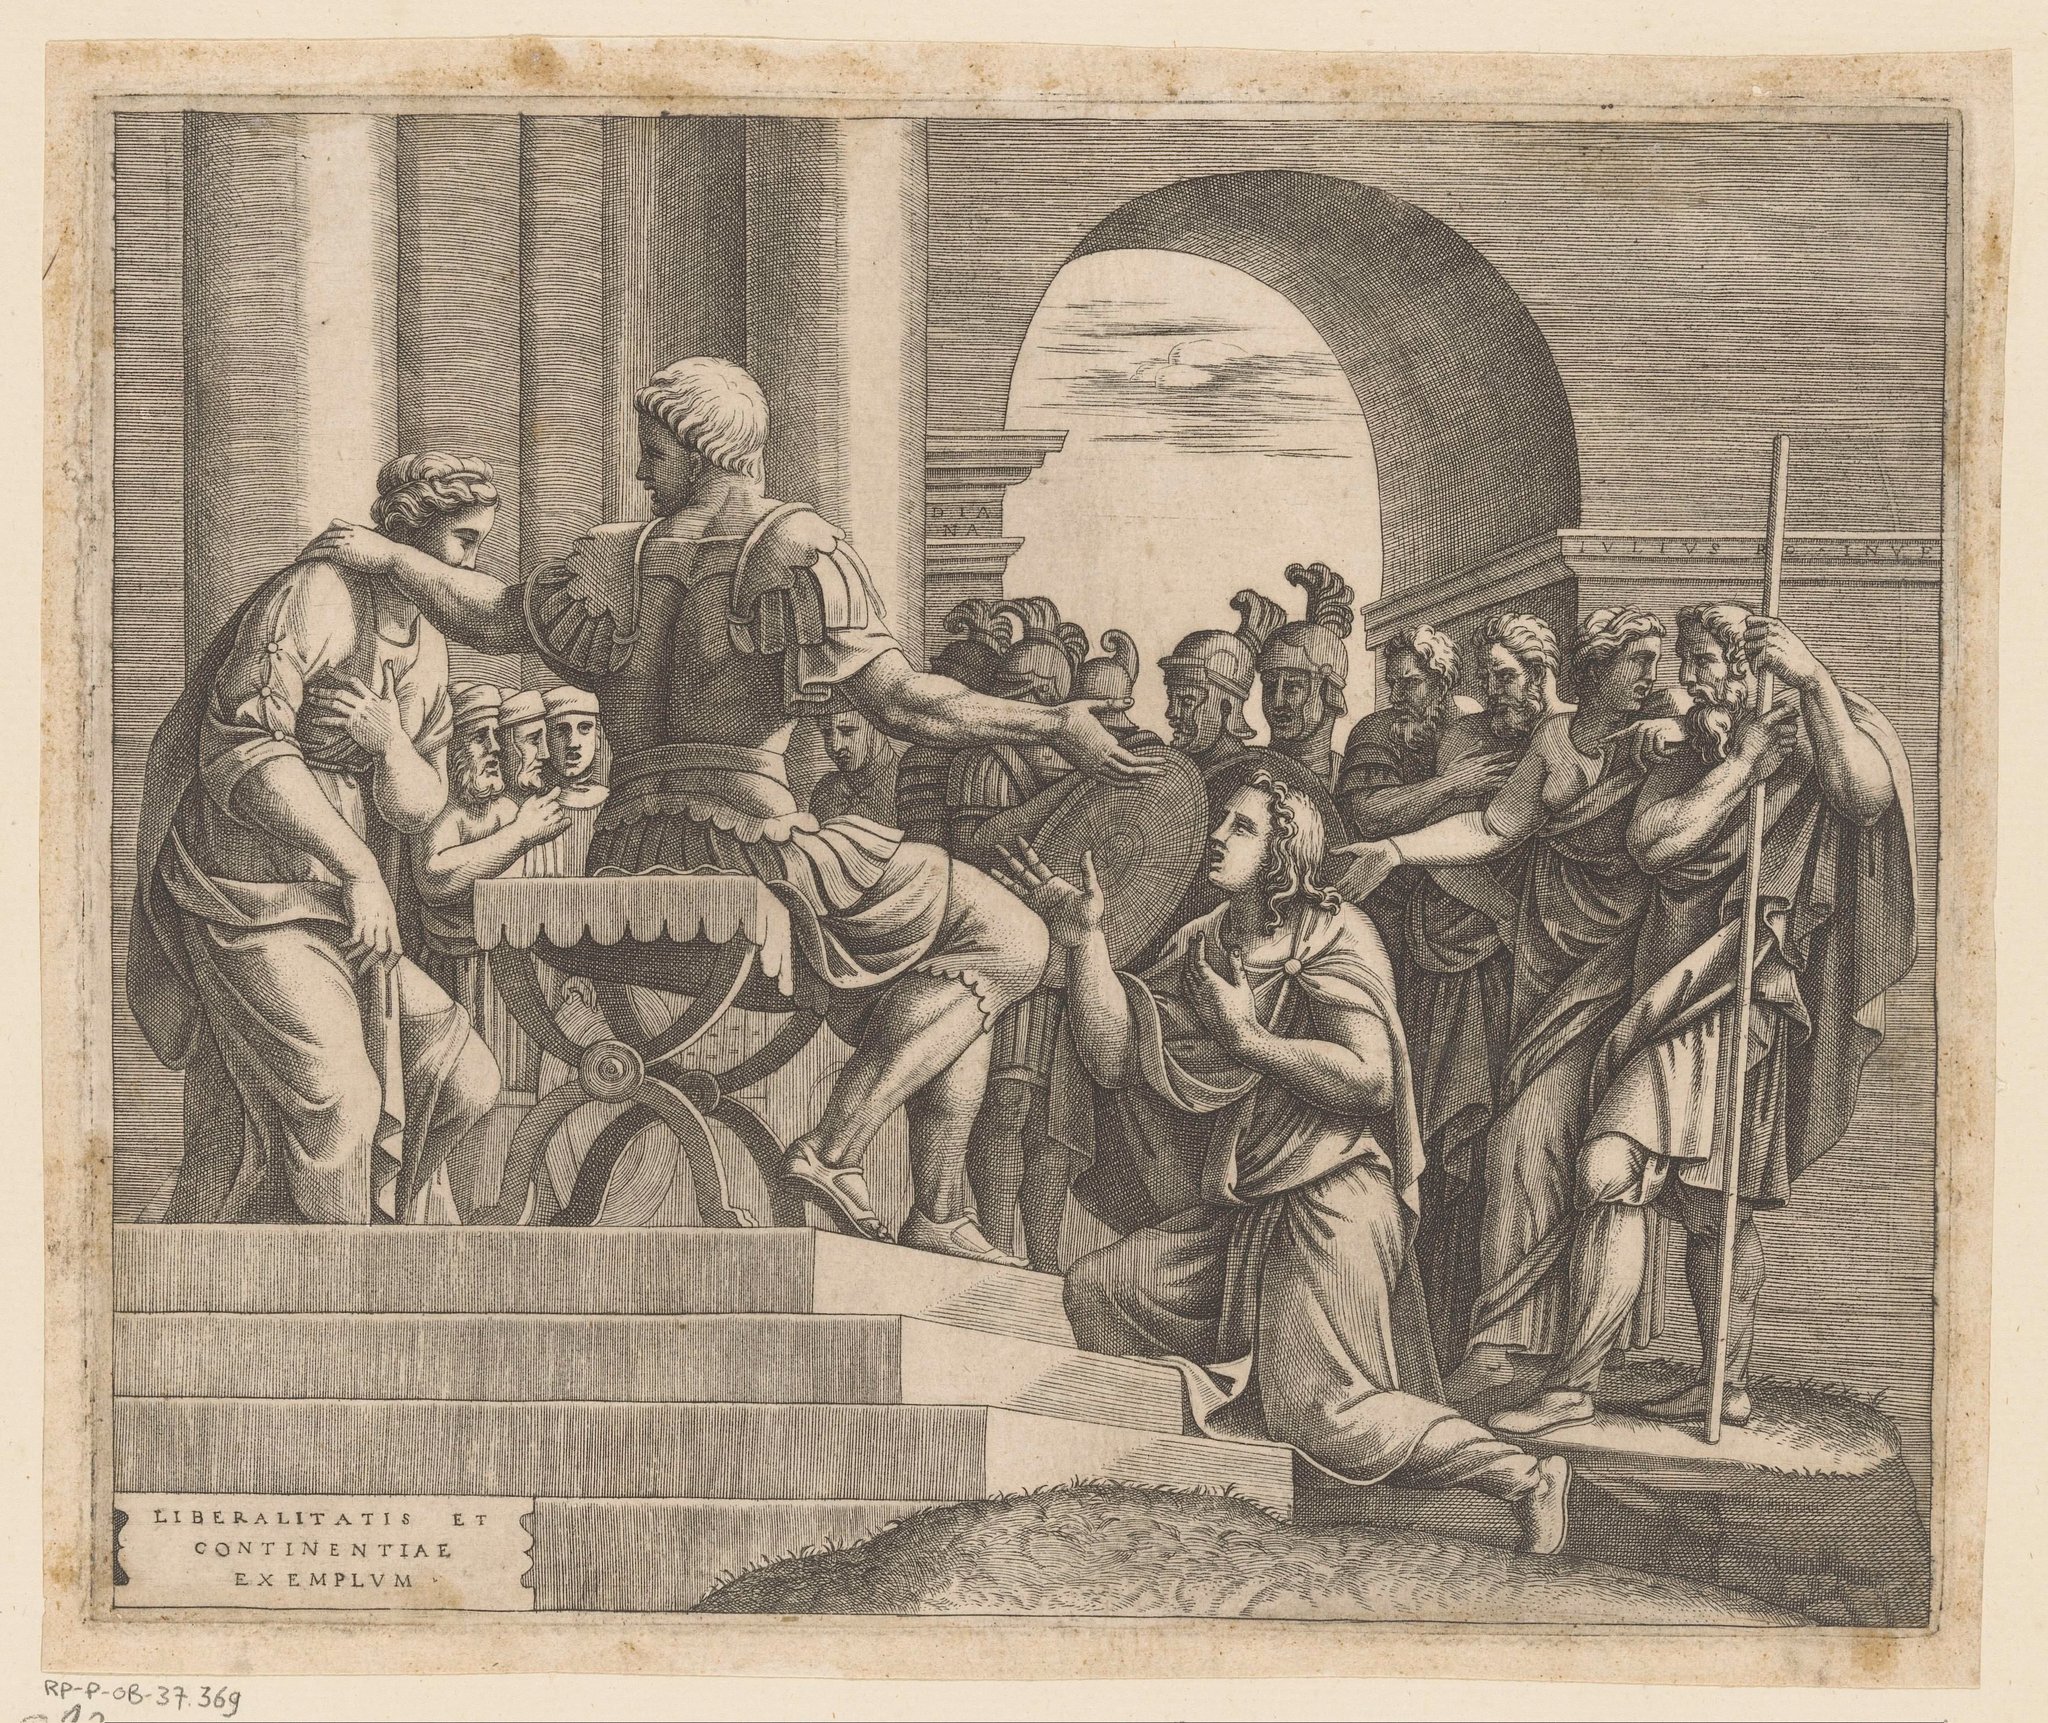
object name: print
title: The Continence of Scipio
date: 1557-1612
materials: paper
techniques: engraving, intaglio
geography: italy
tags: the continence of scipio: he restores a captive woman to her bridegroom allucius, who kneels before him; the ransom offered by the bride's parents is given to allucius as a wedding-gift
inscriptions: collector's mark: Lugt 240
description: The seated man is the Roman general Scipio. He had taken prisoner the fiancée of his defeated opponent Allucius and is here magnanimously returning her to him. Traditionally, this act was seen as an example of generosity. Such stories with a moralizing message enjoyed particular popularity in Diana Mantuana’s time. Barbara van den Broeck also depicted the subject, as seen elsewhere in this gallery.